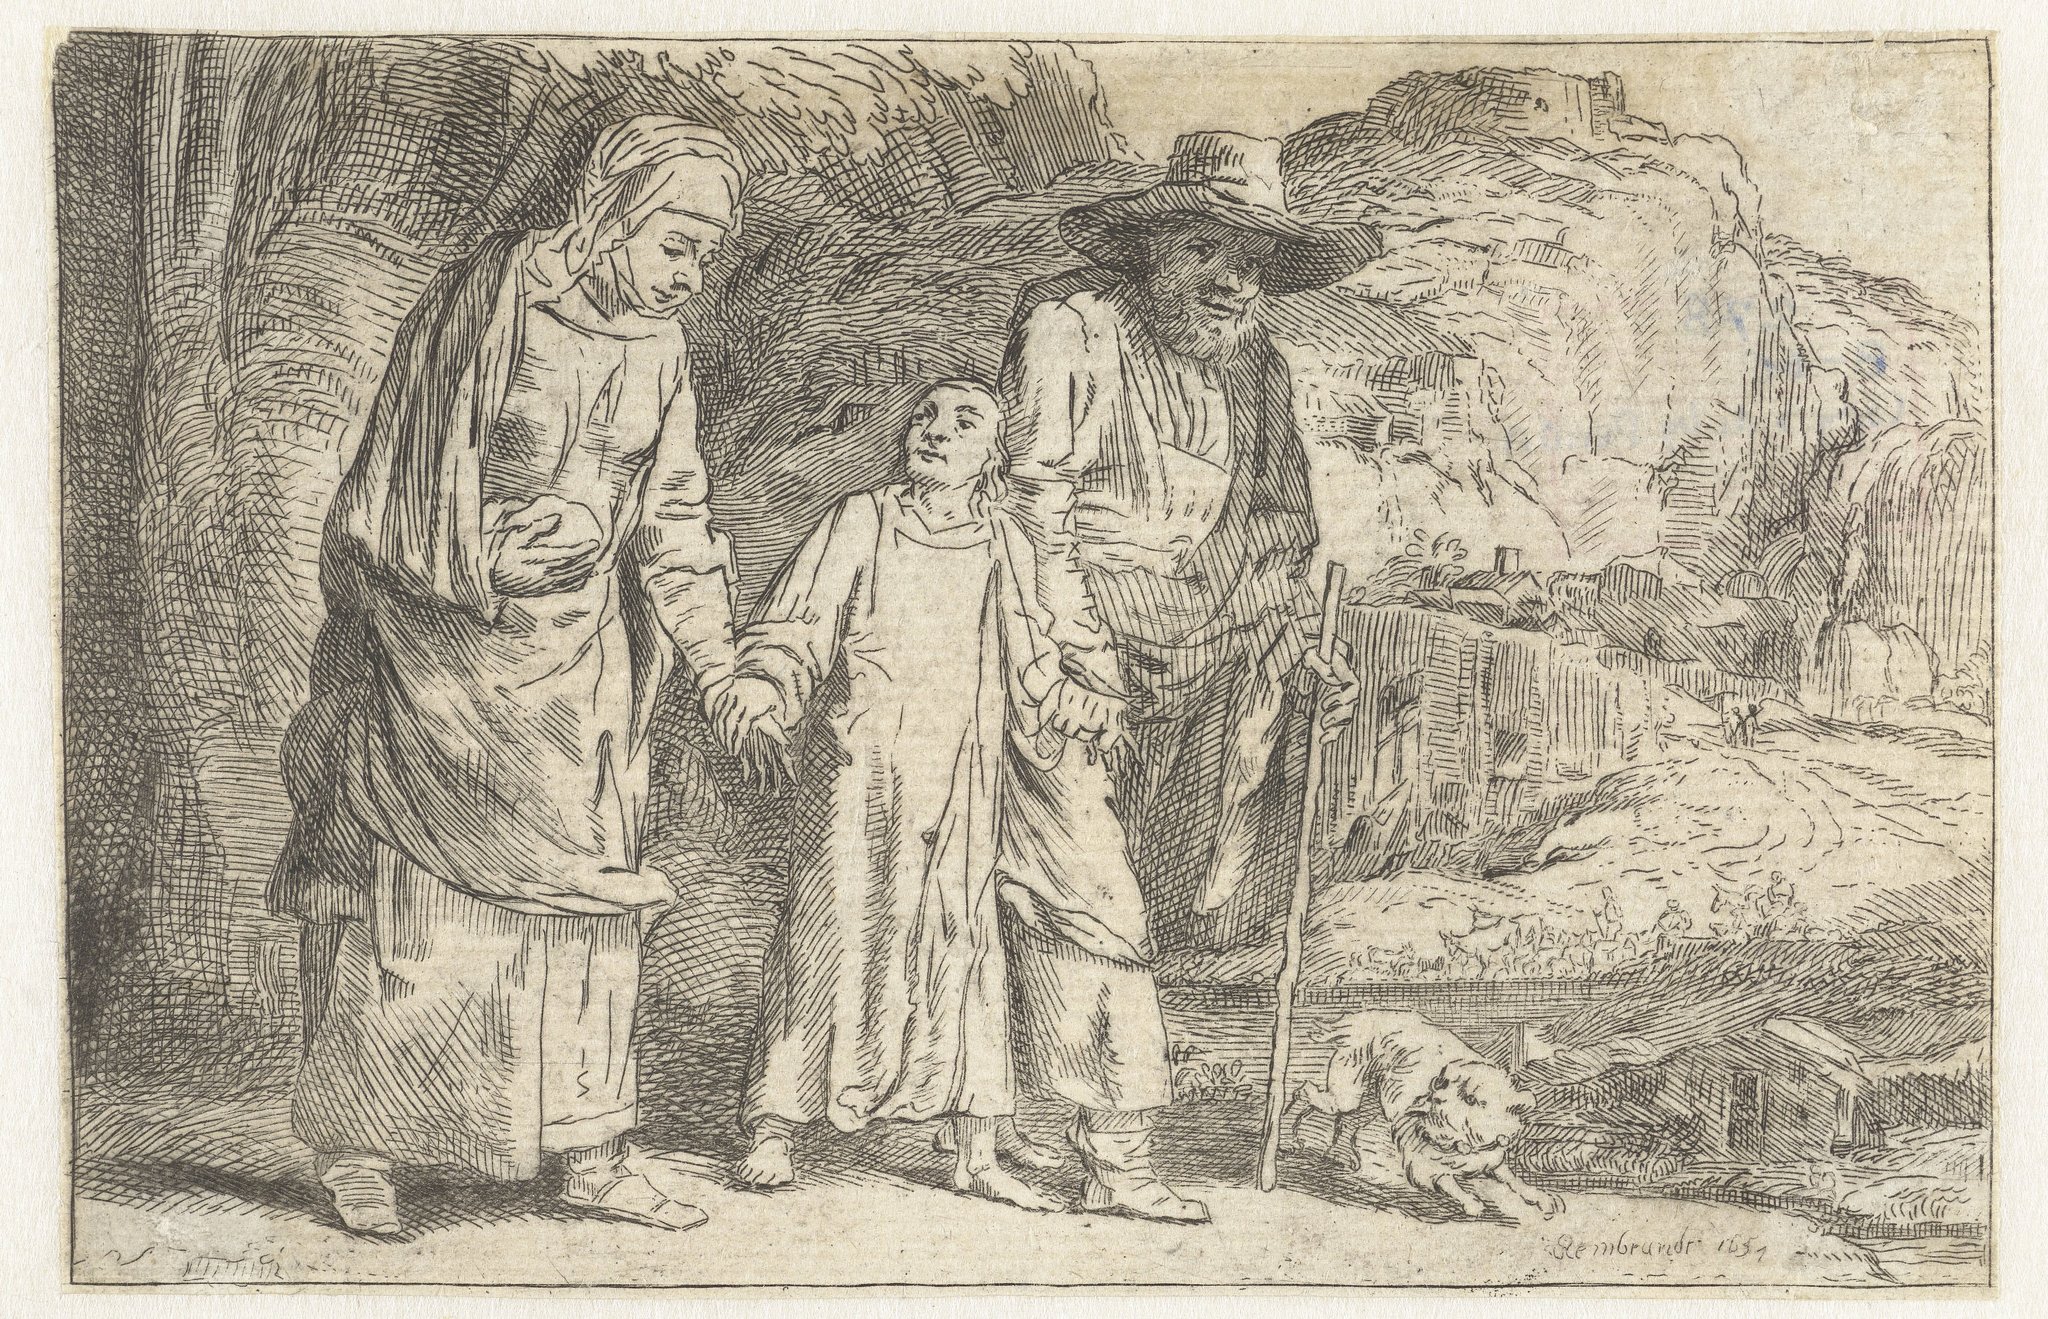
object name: print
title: Christ returning from the temple with his parents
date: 1757-1825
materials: paper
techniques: drypoint, etching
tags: christ returning with his parents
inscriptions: collector's mark: Lugt 2228, stamp, collector's mark: Lugt 2760